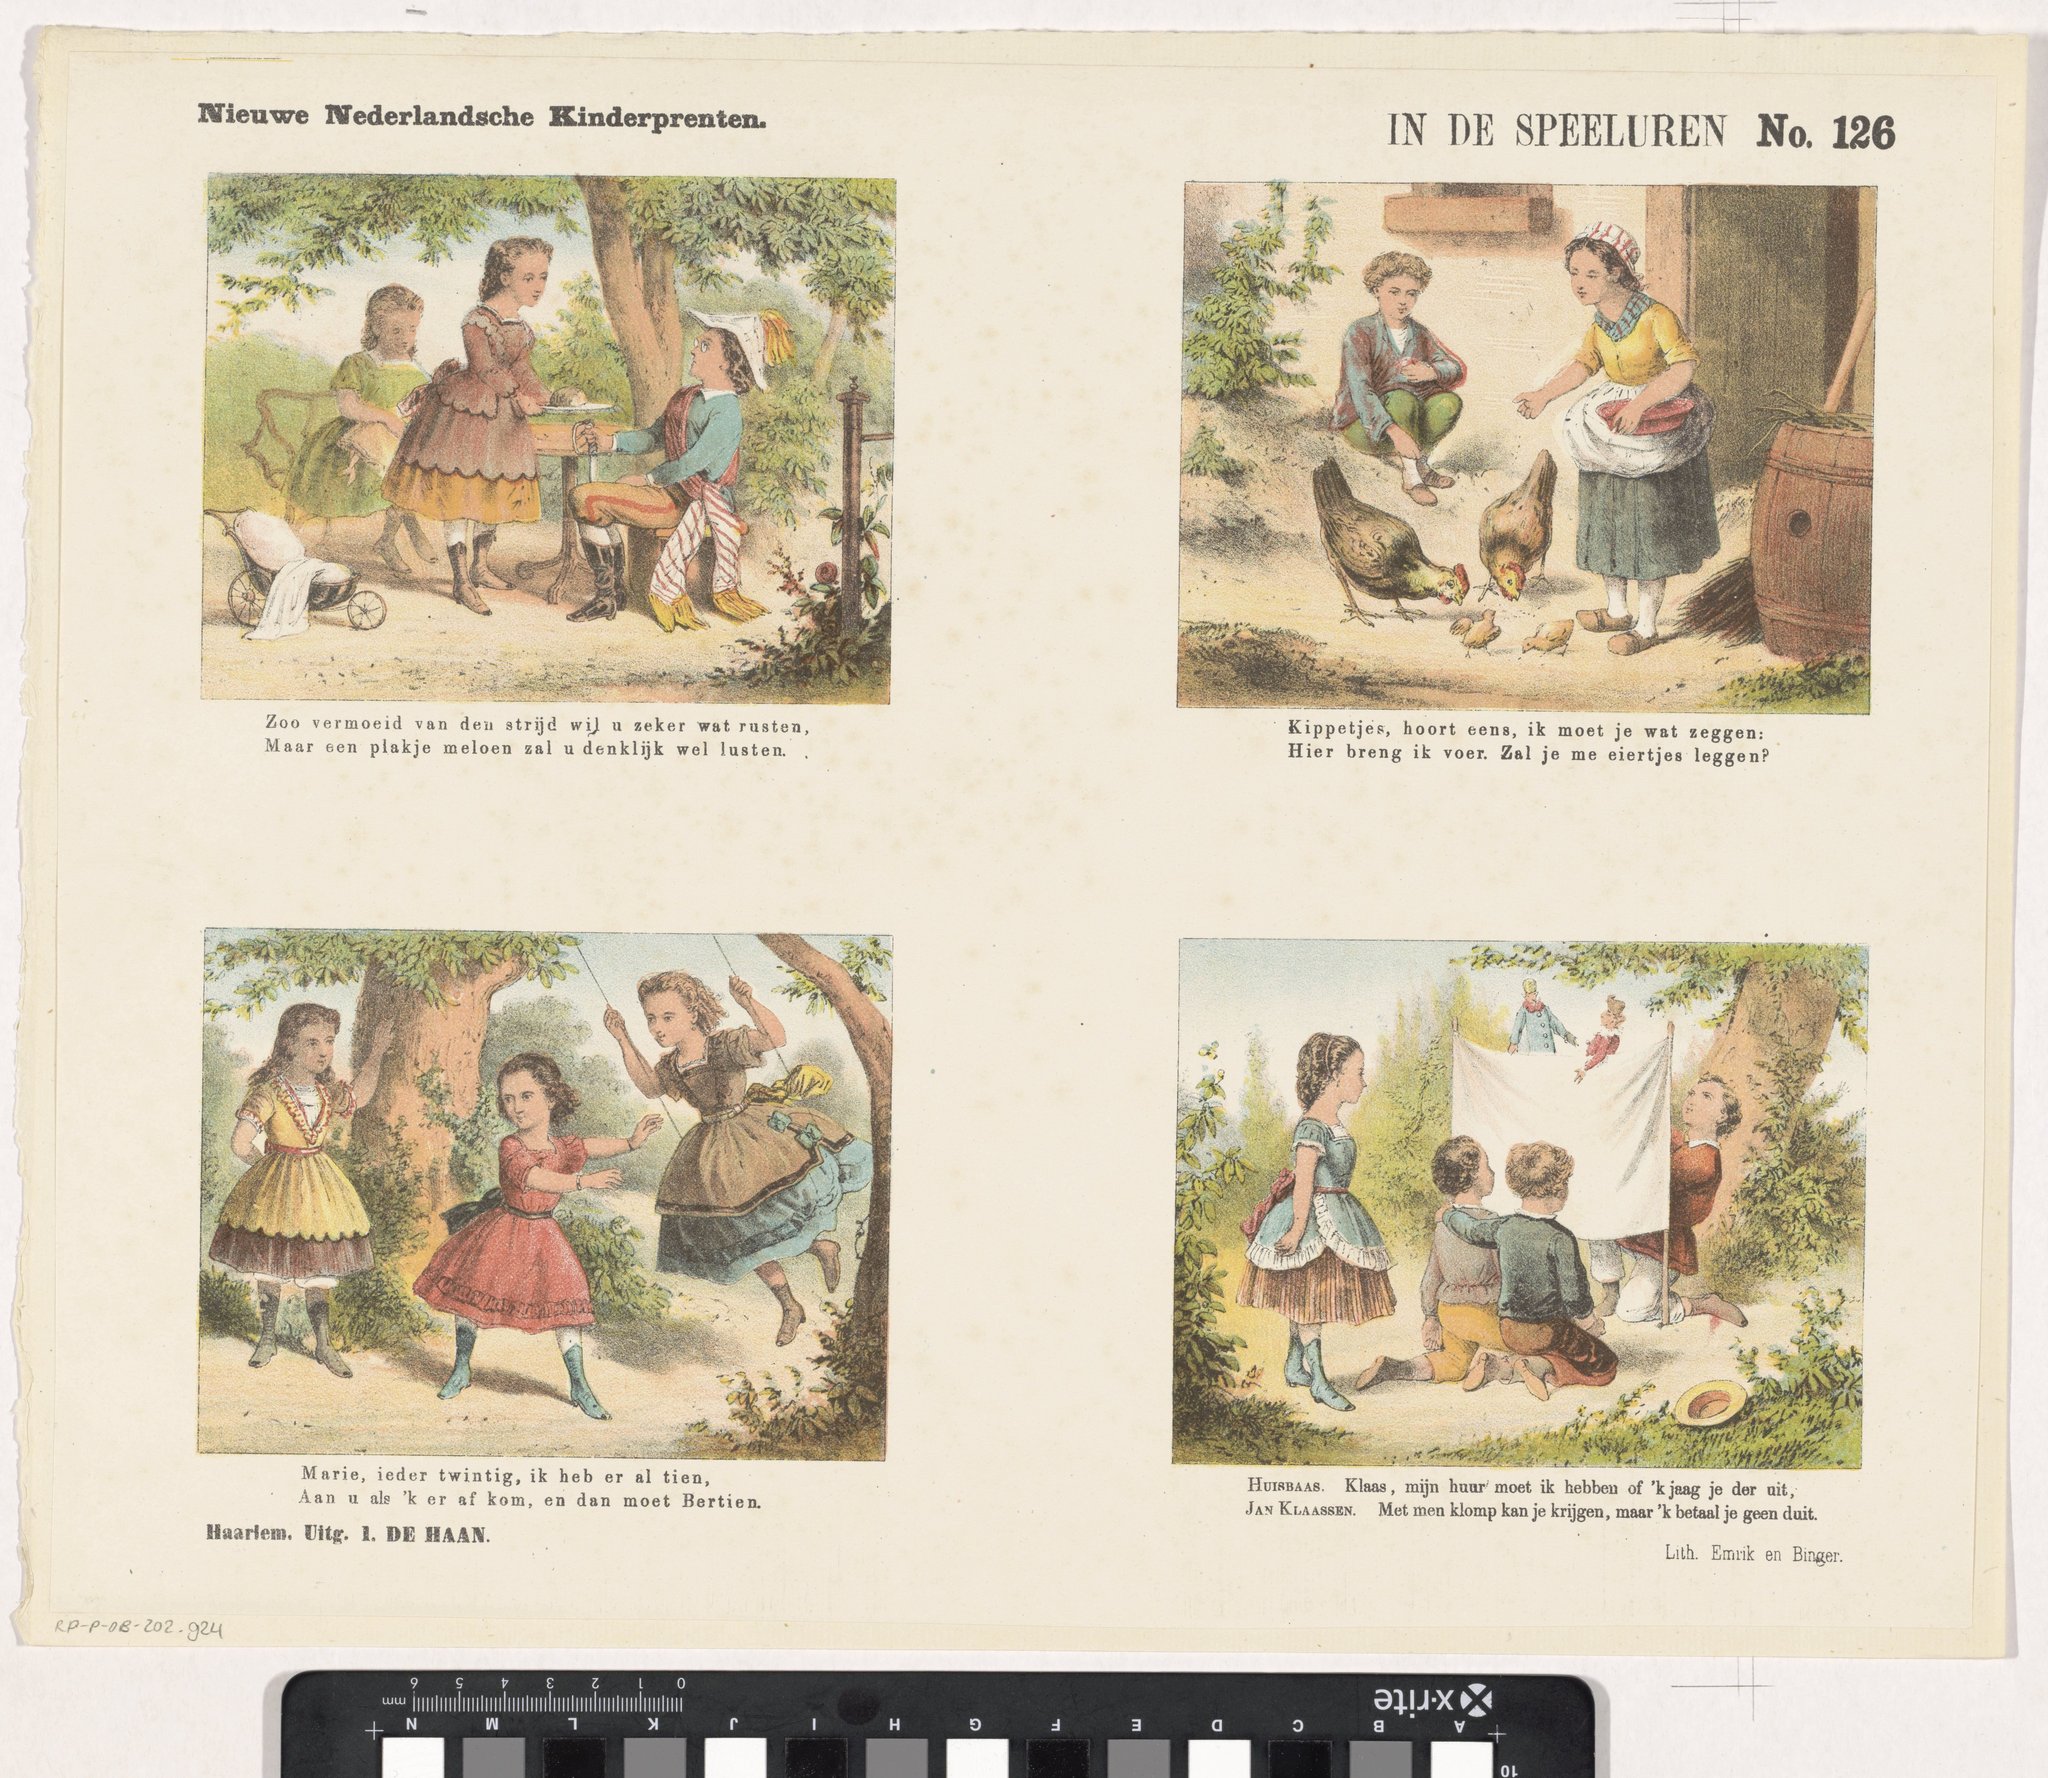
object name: popular print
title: Nieuwe Nederlandsche kinderprenten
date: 1875-1903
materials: paper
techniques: lithograph, letterpress printing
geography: haarlem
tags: fowl (cock, hen, chicken, etc.) (+ feeding animal), children's games and plays, fowl (cock, hen, chicken, etc.), swinging (children's game), puppet and marionette show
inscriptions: collector's mark: Lugt 2760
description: Blad met 4 voorstellingen van kinderspelen en bezigheden, onder andere kippen voeren en schommelen. Onder elke voorstelling een tweeregelig vers. Genummerd rechtsboven: No. 126.